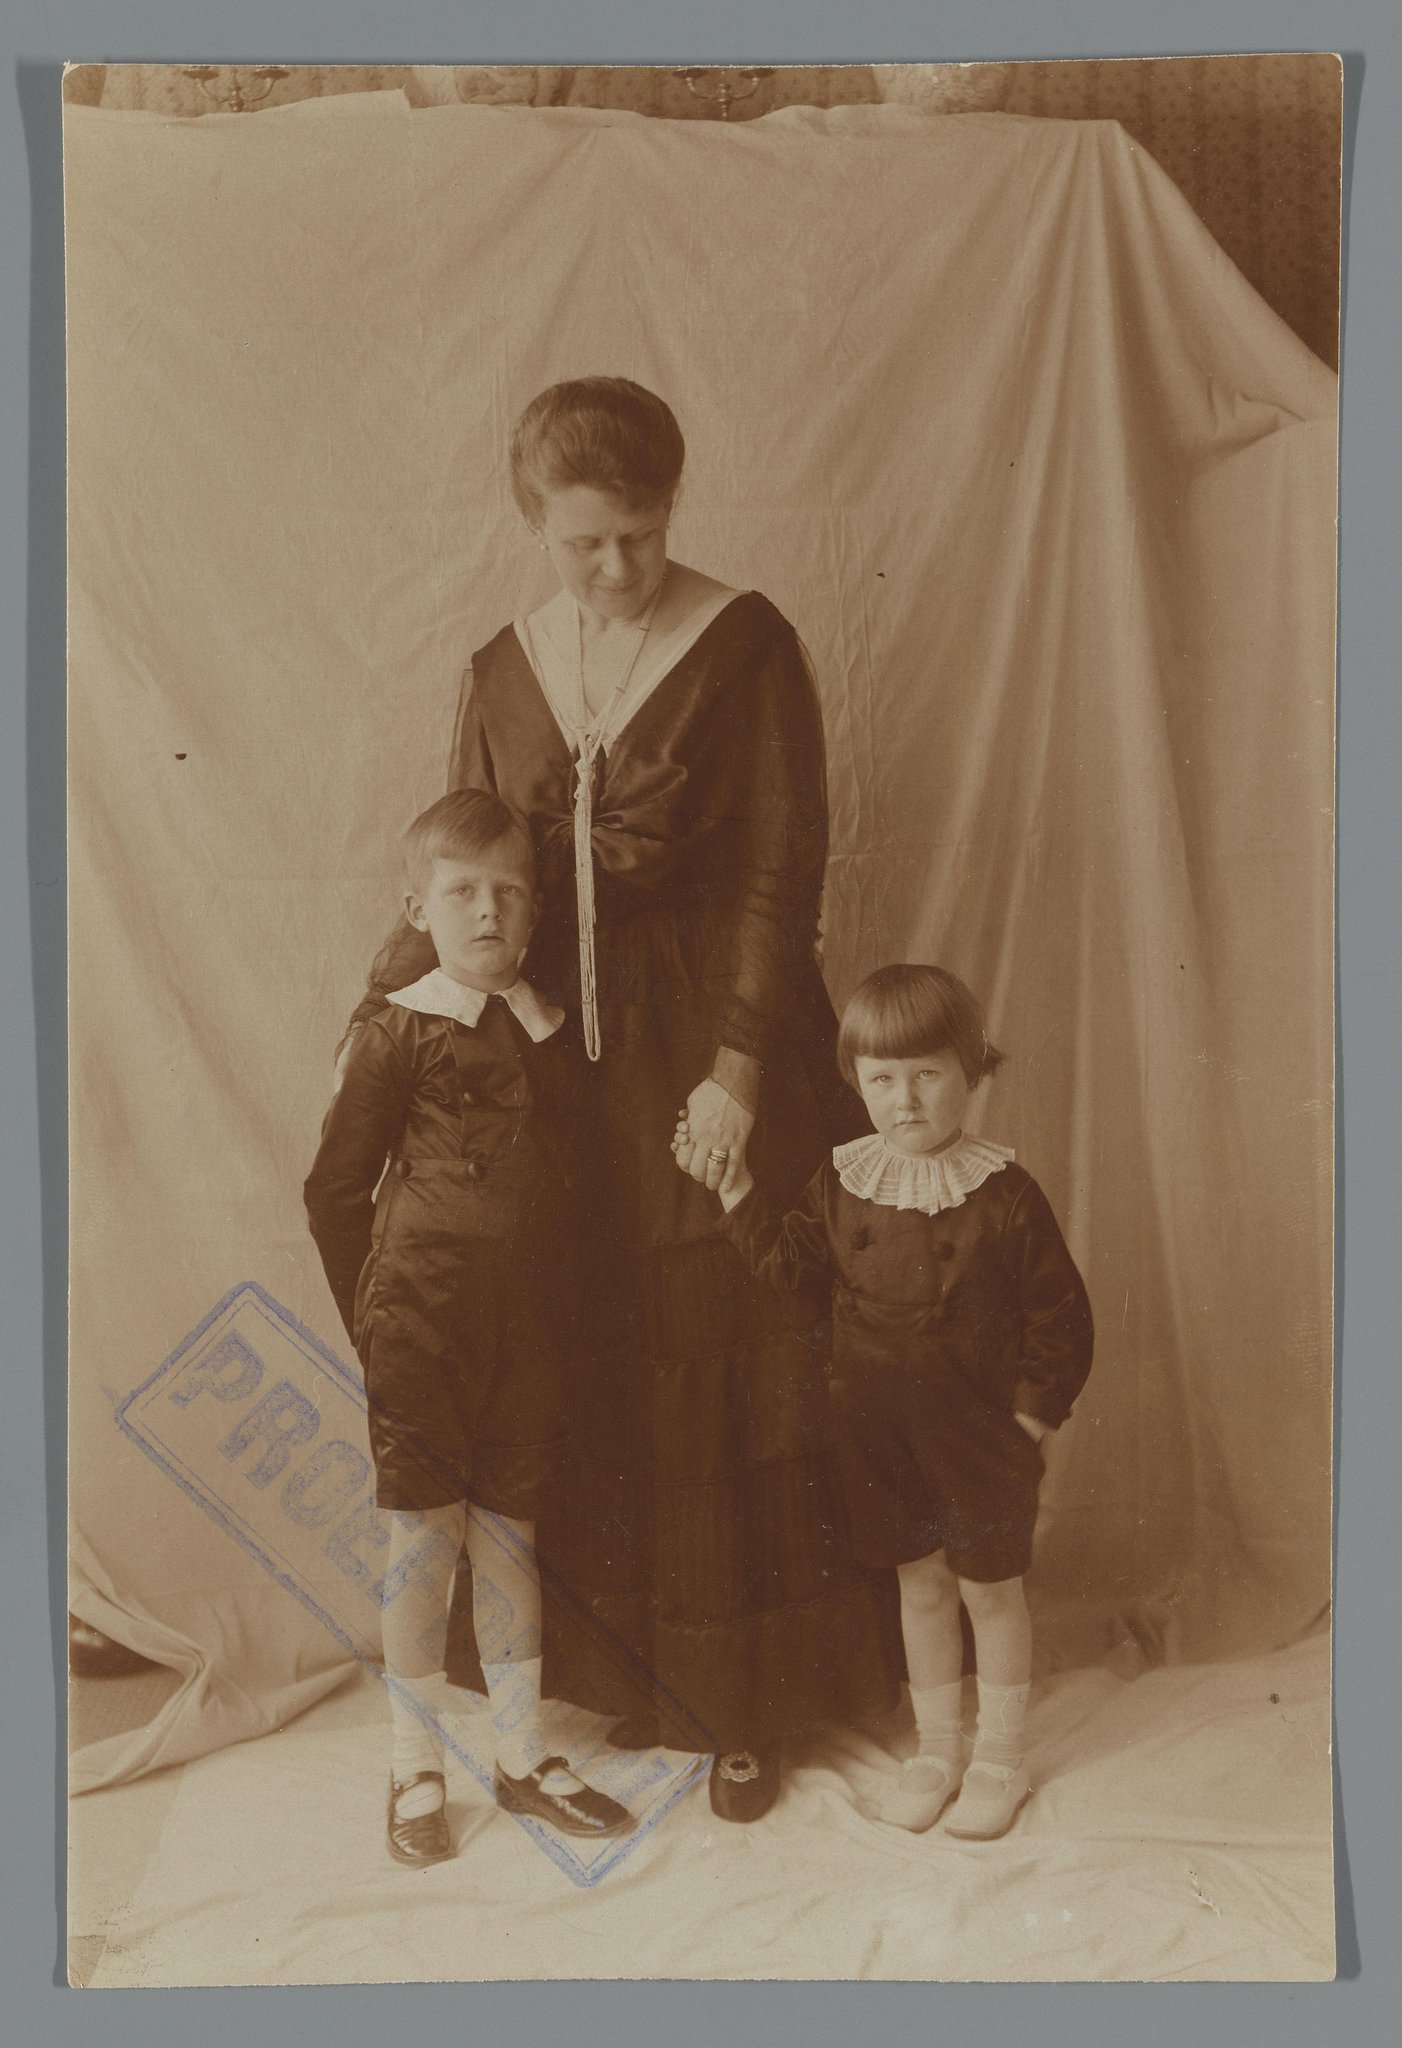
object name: photograph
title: Line van den Berg en twee kinderen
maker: hendrik herman van den berg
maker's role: amateurfotograaf, jurist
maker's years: 1875-1944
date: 1905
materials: photographic support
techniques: photography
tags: caroline louise van den berg-van den berg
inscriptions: stamp: ‘PROEFDRUK’, date: ‘1905’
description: Staande vrouw en twee kinderen; een jongen en een meisje.